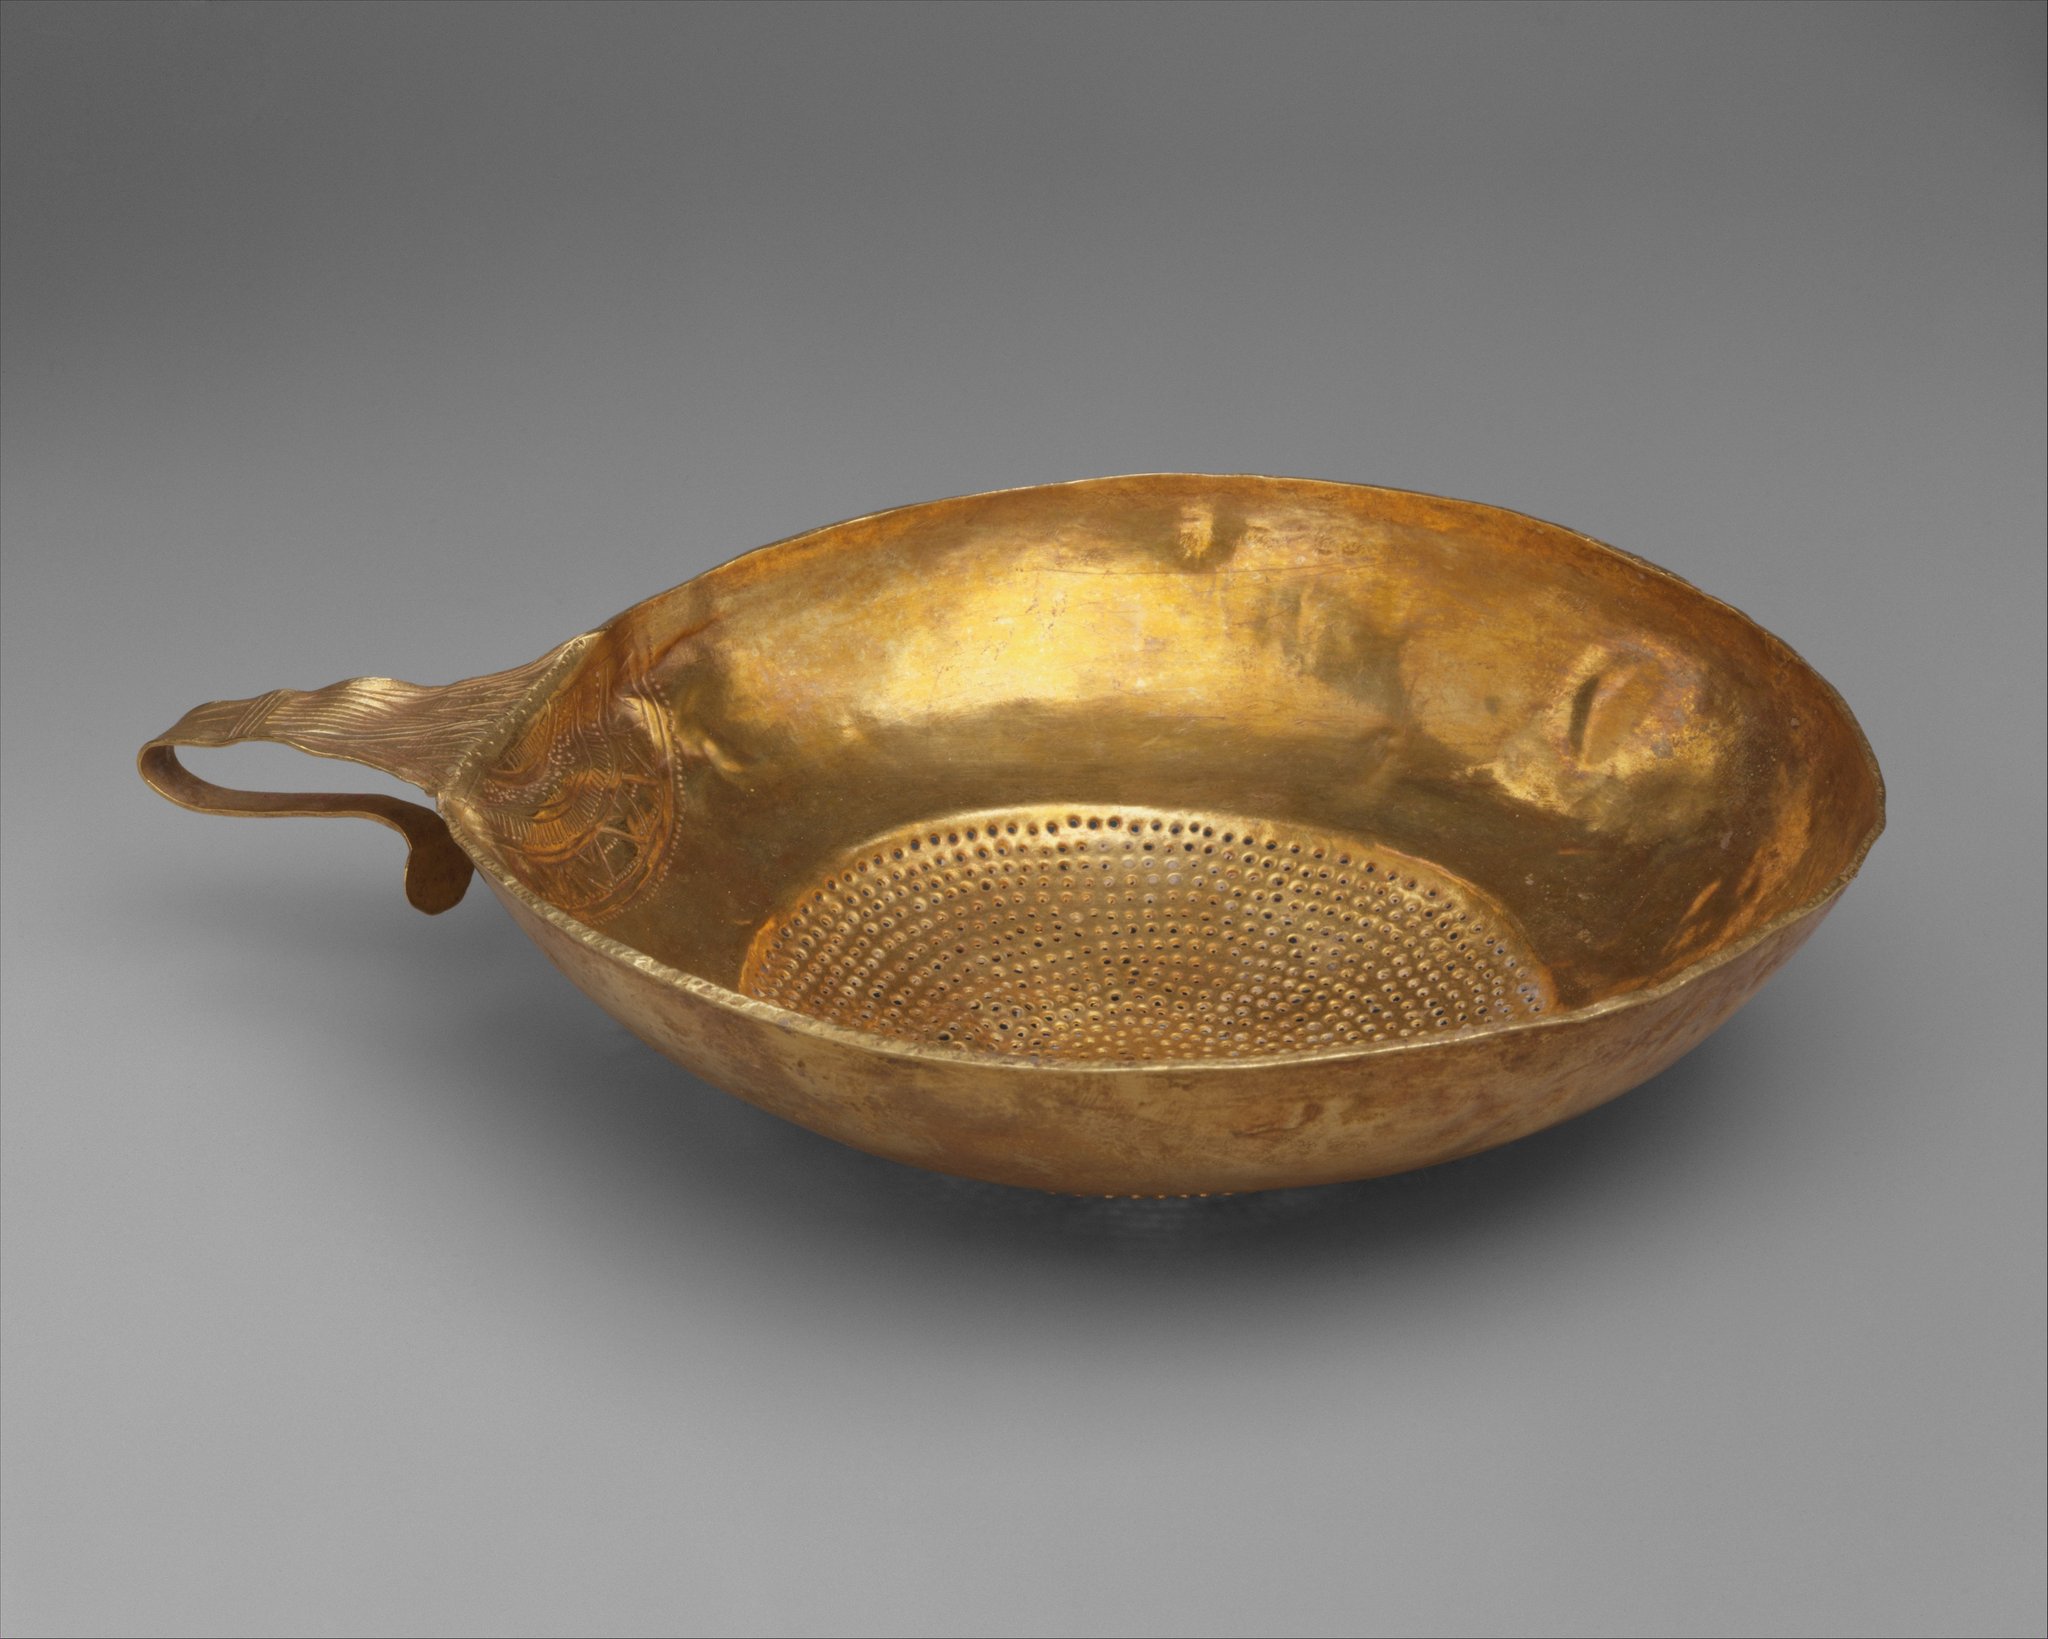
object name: strainer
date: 1279-1213 BCE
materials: gold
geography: egypt